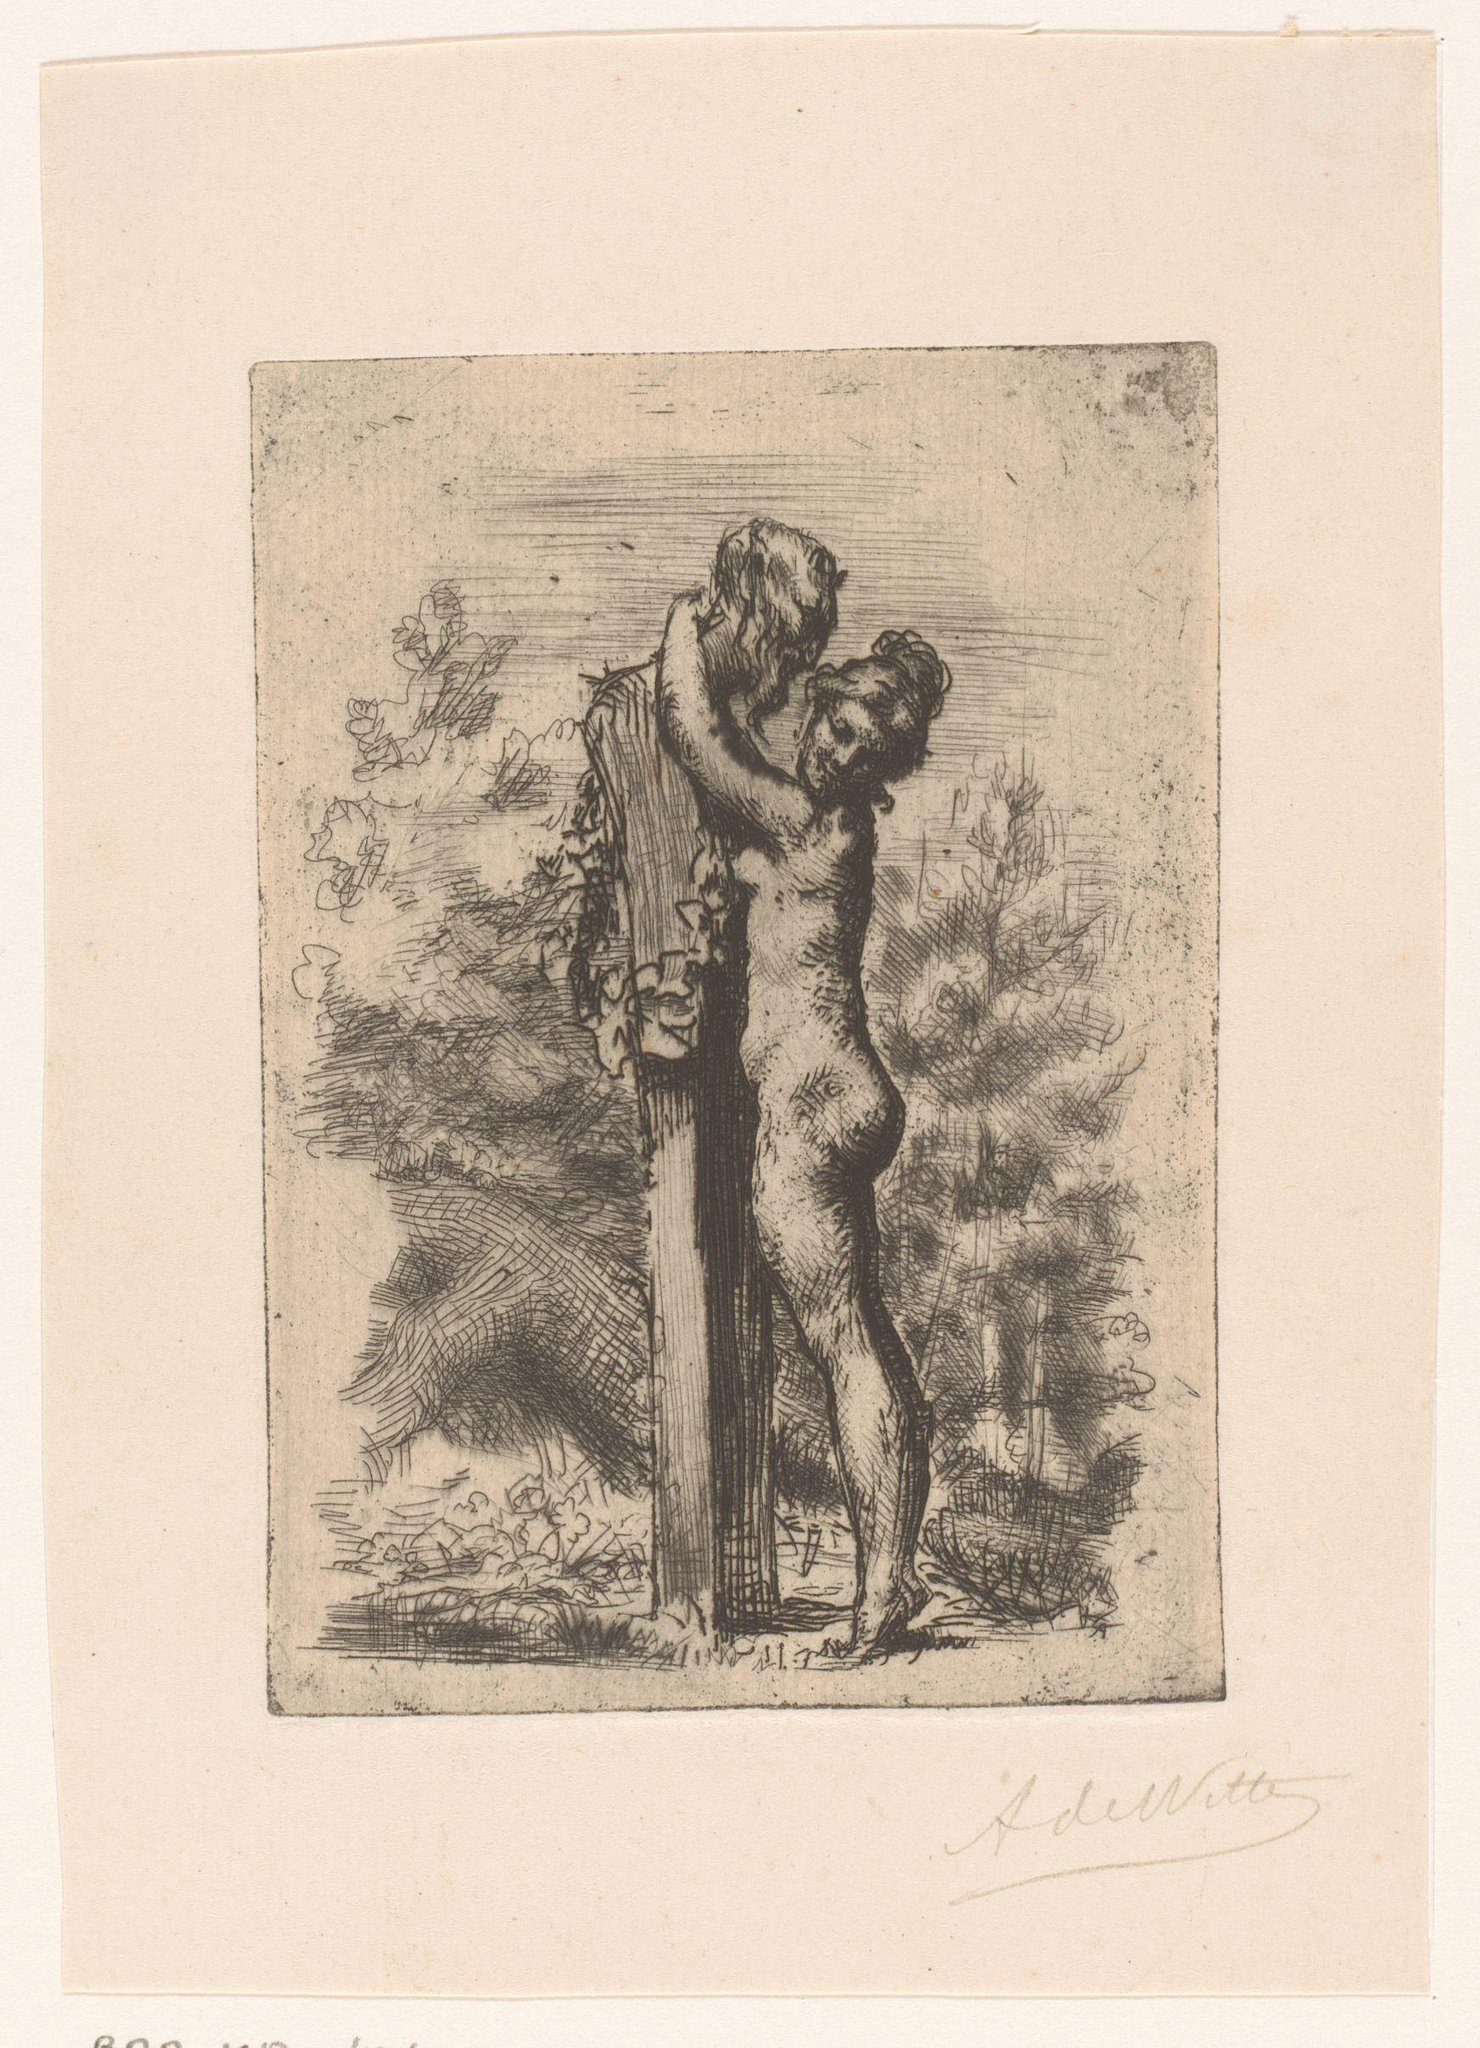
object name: print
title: Staande naakte vrouw bij omkranste herme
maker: adrien de witte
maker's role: print maker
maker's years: 1850-1935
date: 1860-1913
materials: paper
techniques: etching, intaglio, retroussage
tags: herms (garden ornaments), the (nude) human figure; 'corpo humano' (ripa) - aa - female human figure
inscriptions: collector's mark: Lugt 2228